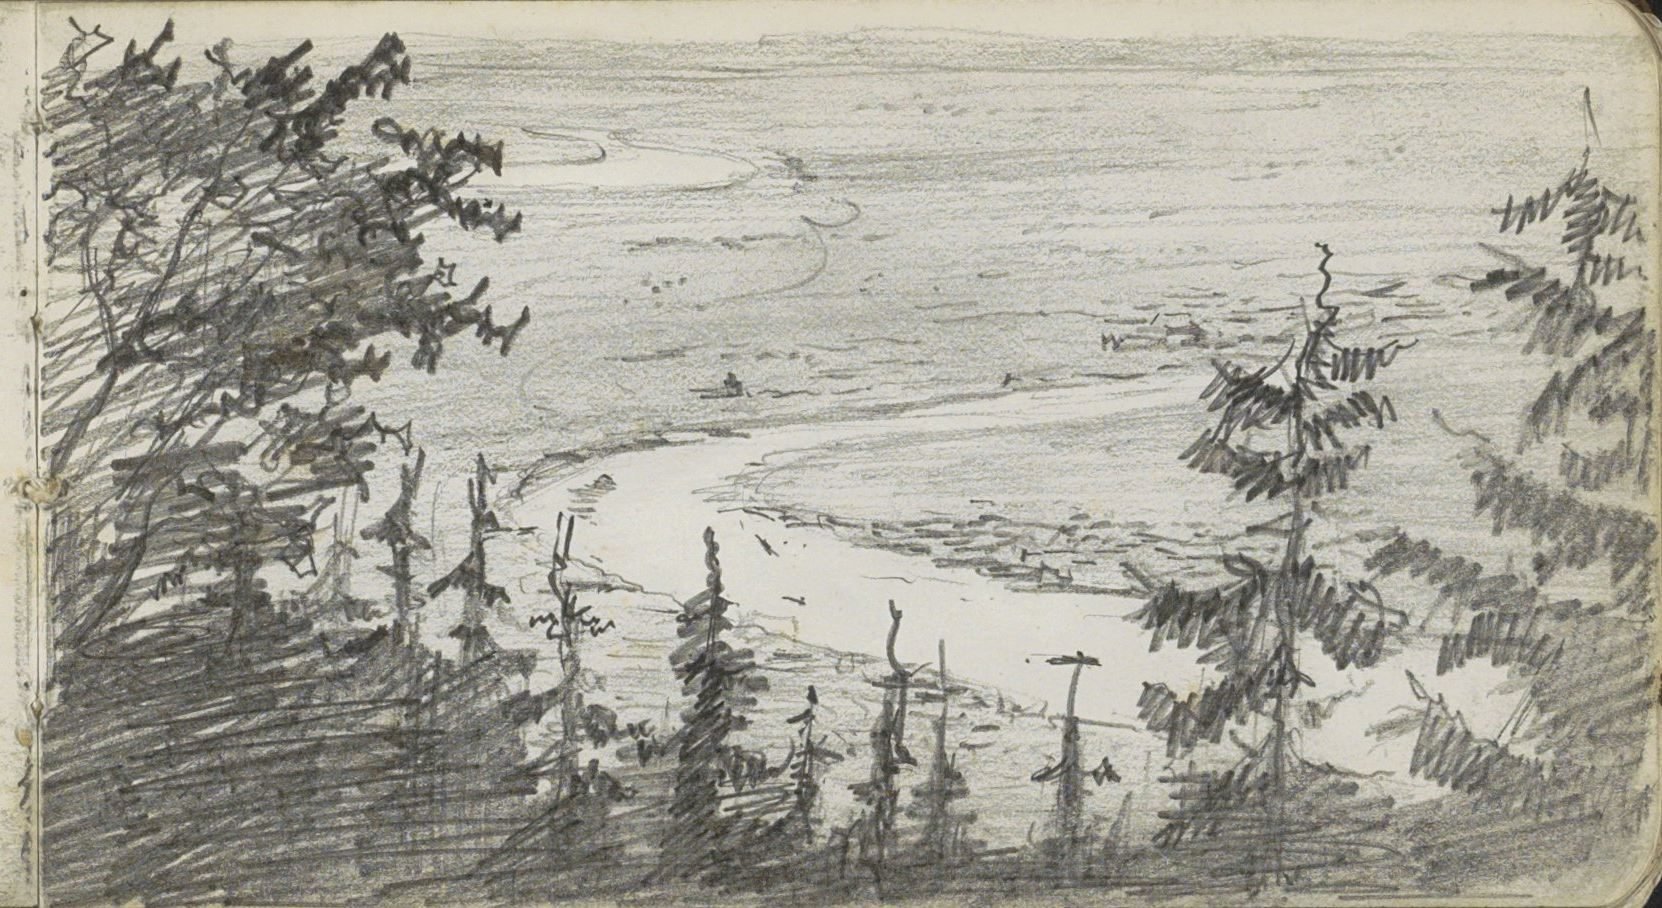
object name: sketchbook leaf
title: Tauberdal te Königshofen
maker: geo poggenbeek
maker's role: draughtsman, painter, print maker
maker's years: 1853-1903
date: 1806-1876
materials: paper, pencil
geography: lauda-königshofen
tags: dale, valley, river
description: Landschap met naaldbomen en de rivier de Tauber in het dal. Blad 3 recto uit een schetsboek met 69 bladen.